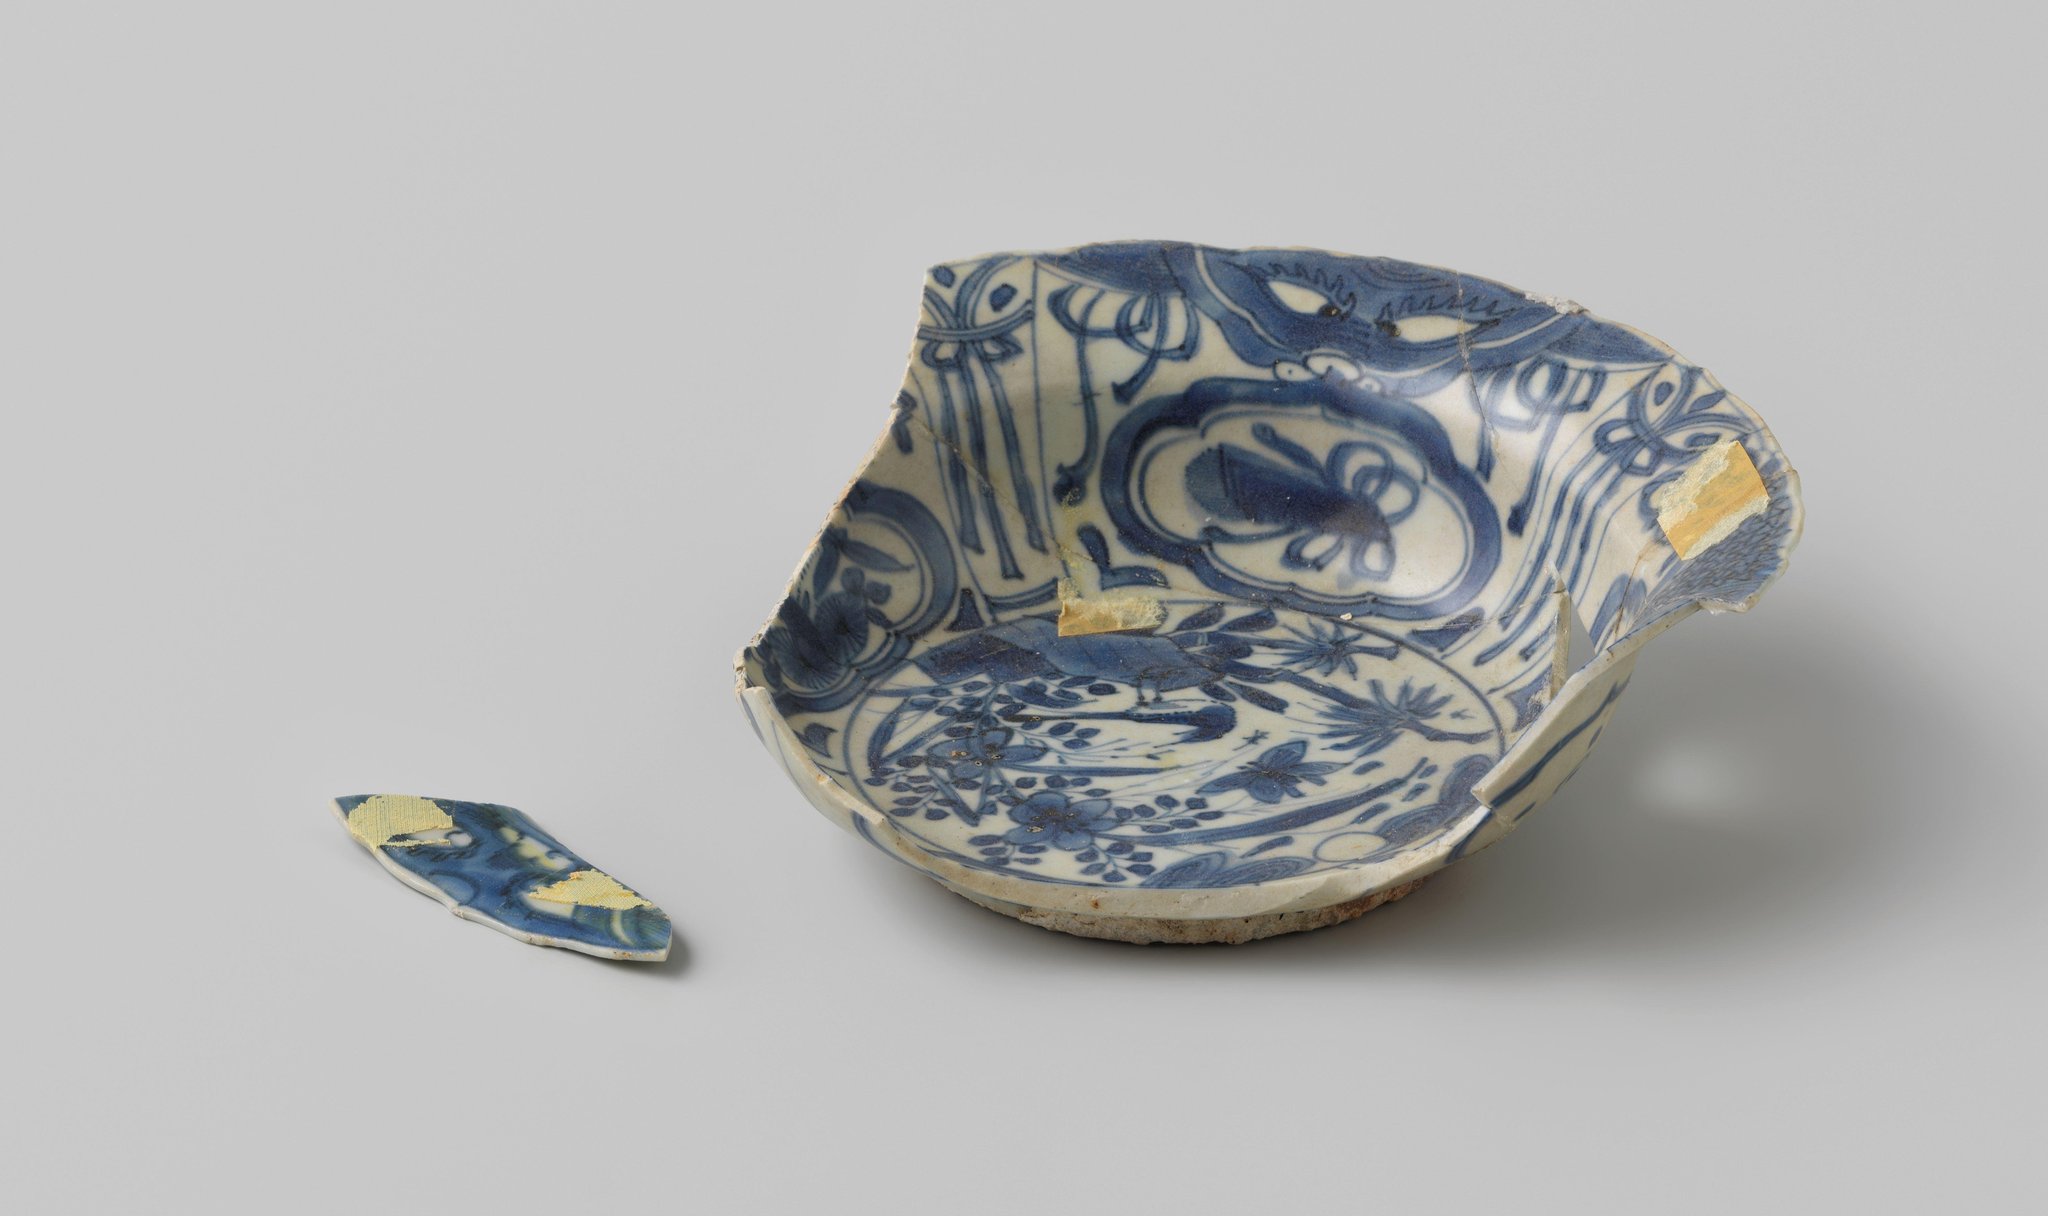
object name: deep dish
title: Fragment diep bord uit V.O.C.-schip de 'Witte Leeuw'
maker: Anonymous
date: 1613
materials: bone china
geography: jingdezhen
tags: verenigde oostindische compagnie, sint-helena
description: A bowl with a flattened rim. Taotie mask and/or borders with diaper patterns. A central decoration of a bird on a rock near bamboo and a butterfly. Panels decorated with flowers and symbols.